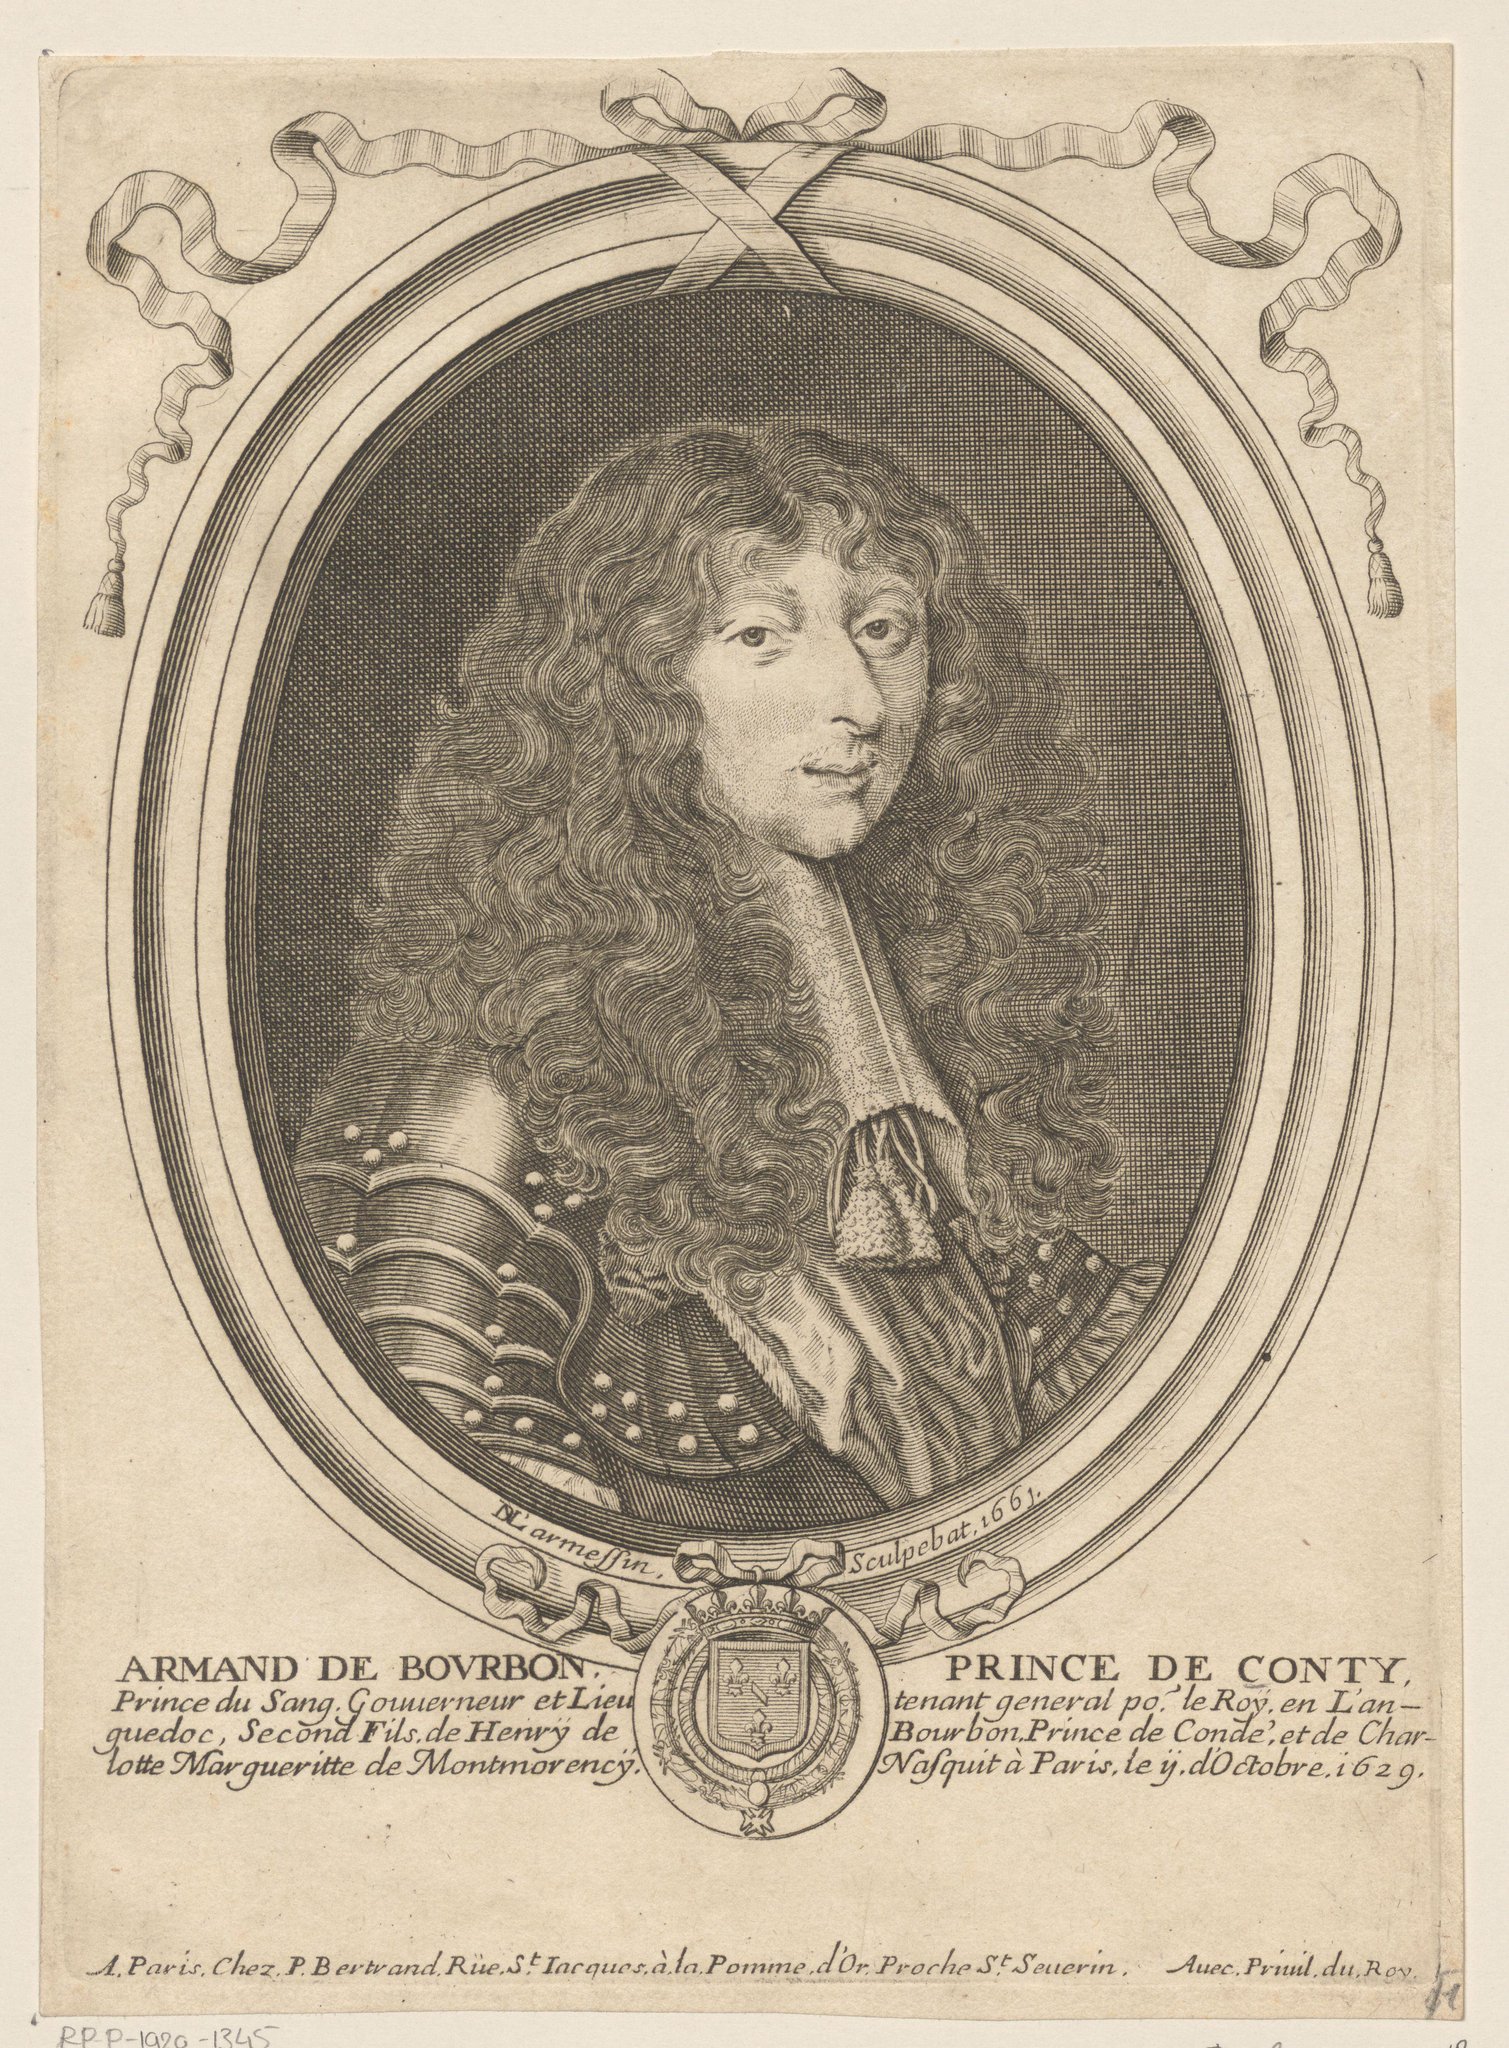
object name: print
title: Portret van Armand de Bourbon-Condé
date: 1661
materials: paper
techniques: engraving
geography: paris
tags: prince, historical persons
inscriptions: collector's mark: Lugt 2228